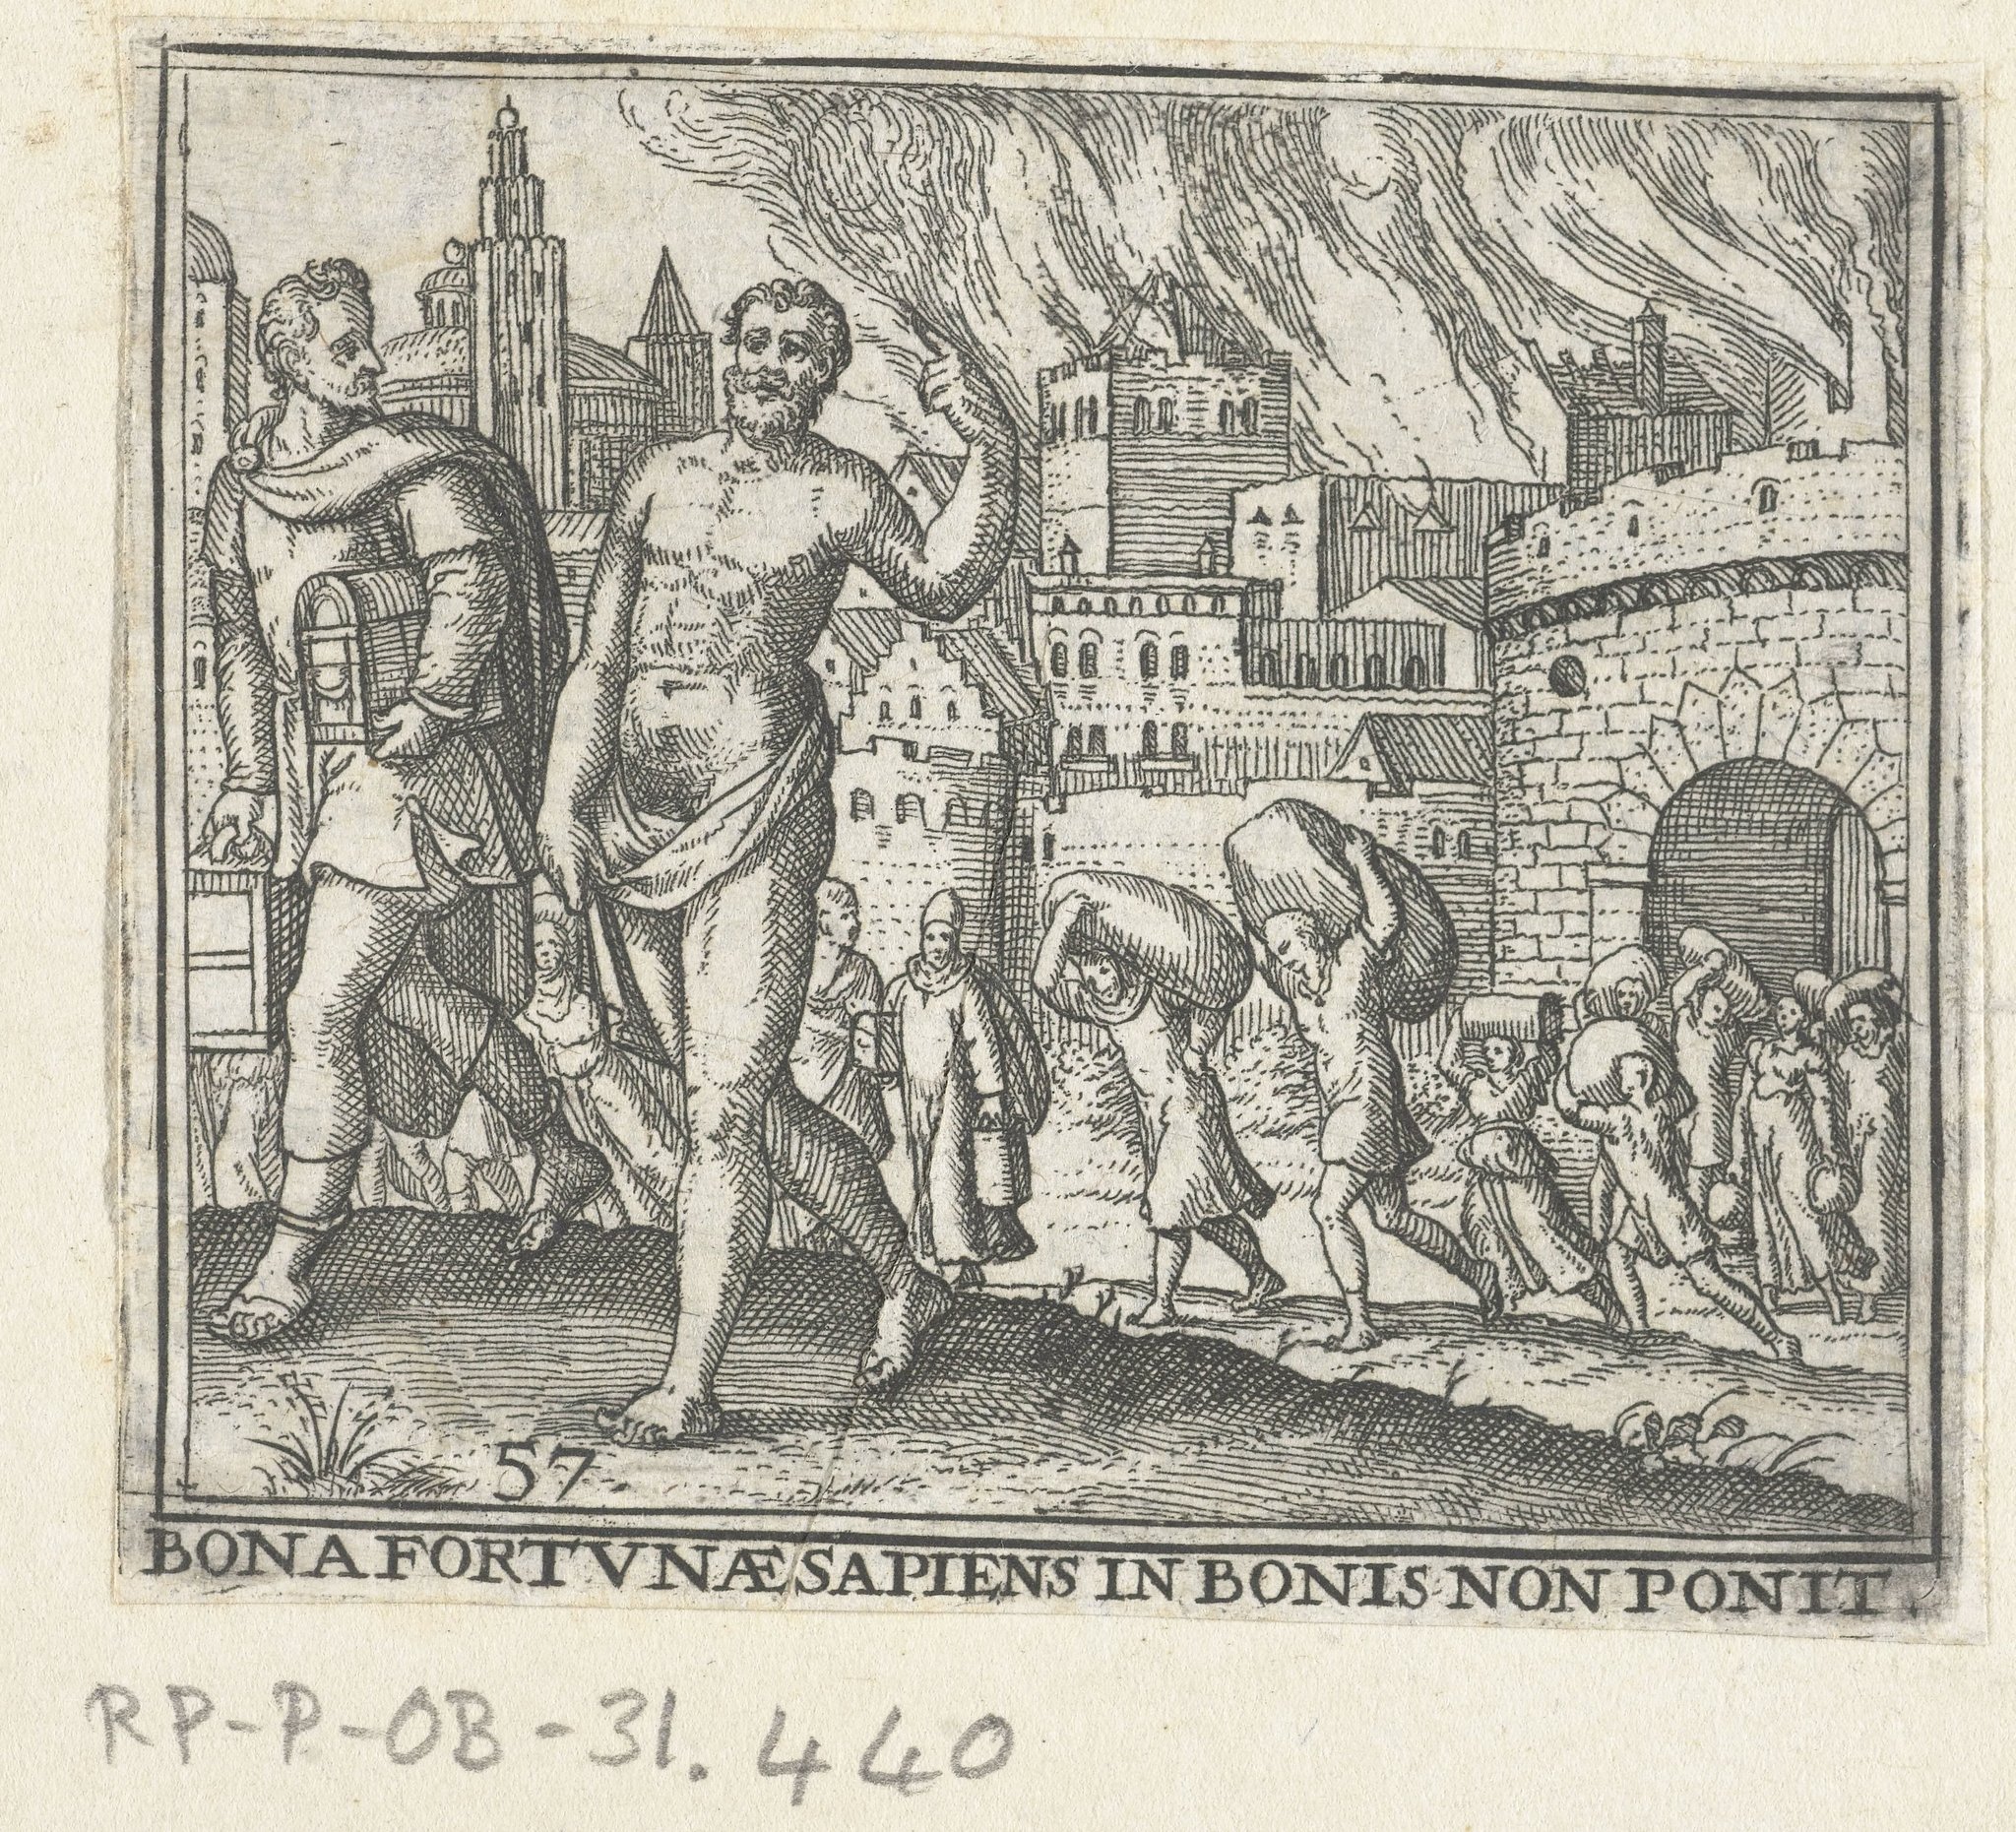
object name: book illustration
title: Denis Lebey de Batilly, Emblemata, 1596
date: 1596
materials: paper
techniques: engraving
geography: frankfurt am main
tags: rescue from fire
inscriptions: collector's mark: Lugt 240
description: Een groep mensen vertrekt uit een brandende stad. De mensen dragen hun bezittingen in zakken op de rug. De groep wordt geleid door een naakt man gekleed enkel met een doek om zijn midden.